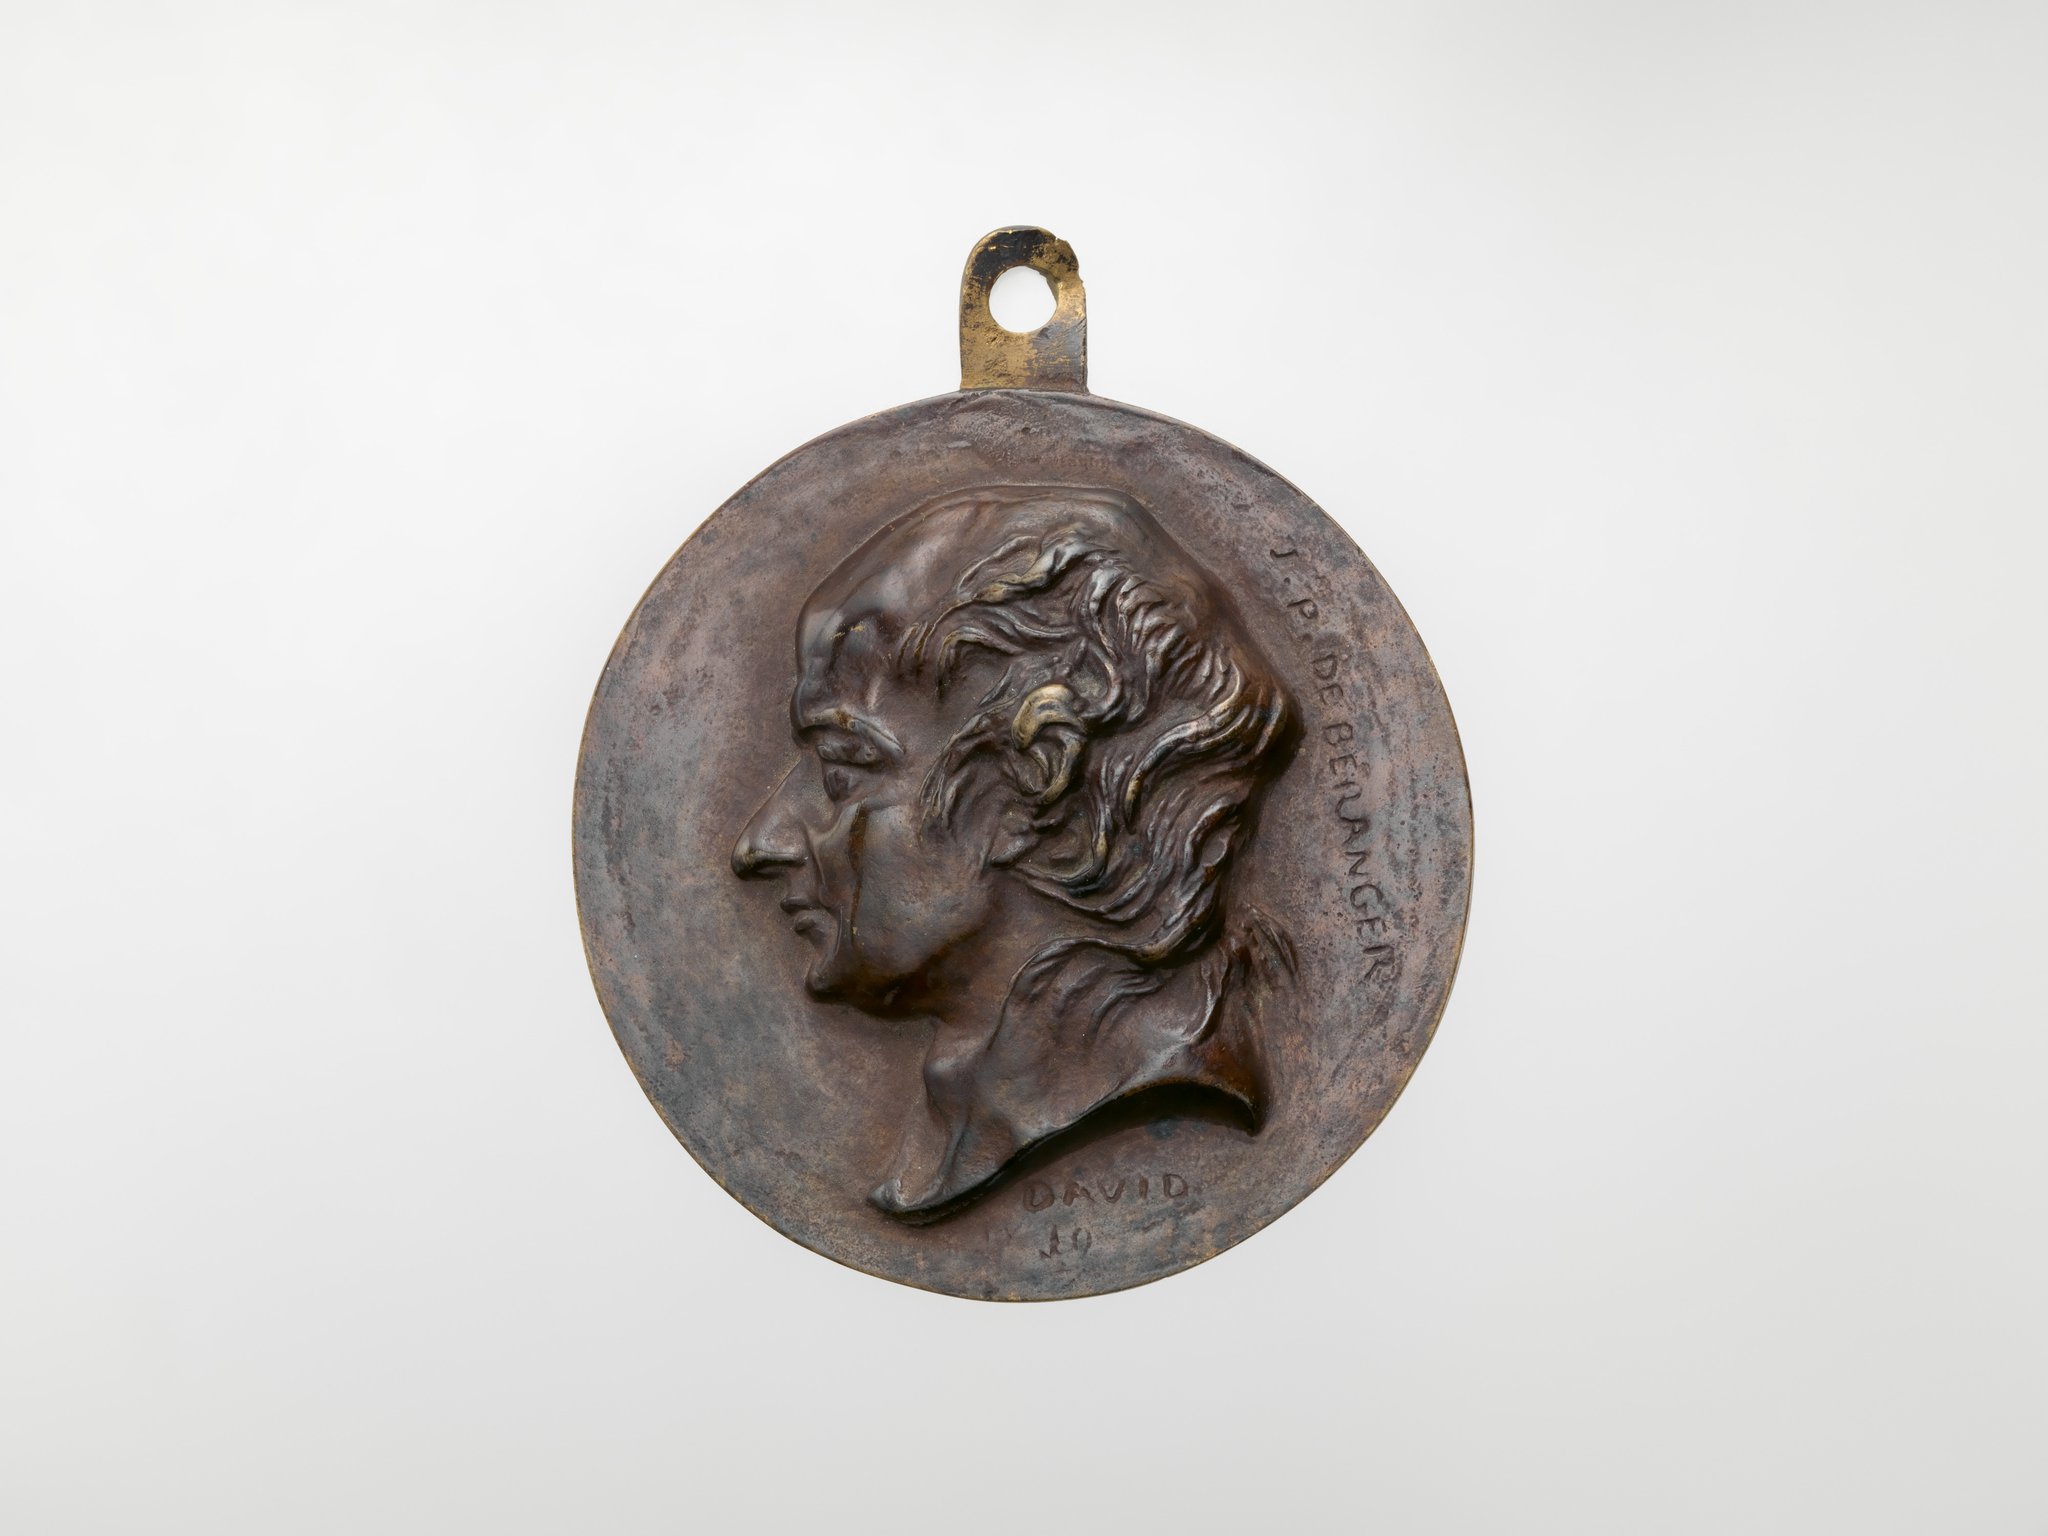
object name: medal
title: Pierre-Jean de Béranger (1780–1857)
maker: pierre jean david d'angers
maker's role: artist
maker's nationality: french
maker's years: 1788-1856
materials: bronze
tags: men,profiles